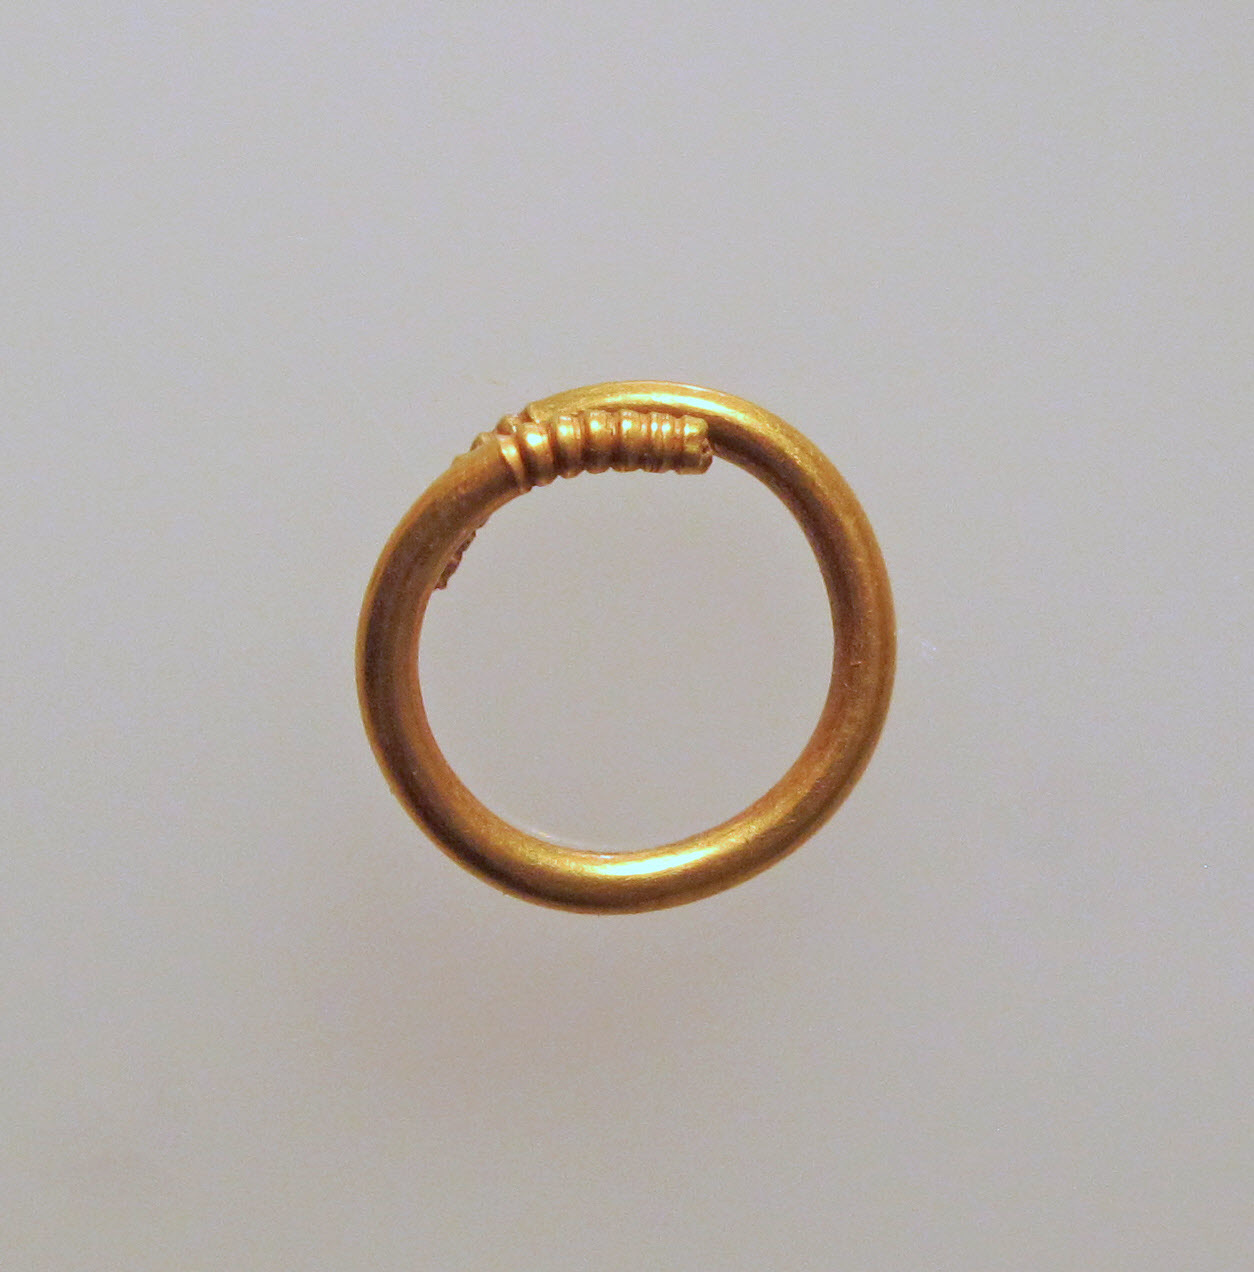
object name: earring or spiral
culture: cypriot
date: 3900 BCE-100 CE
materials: gold